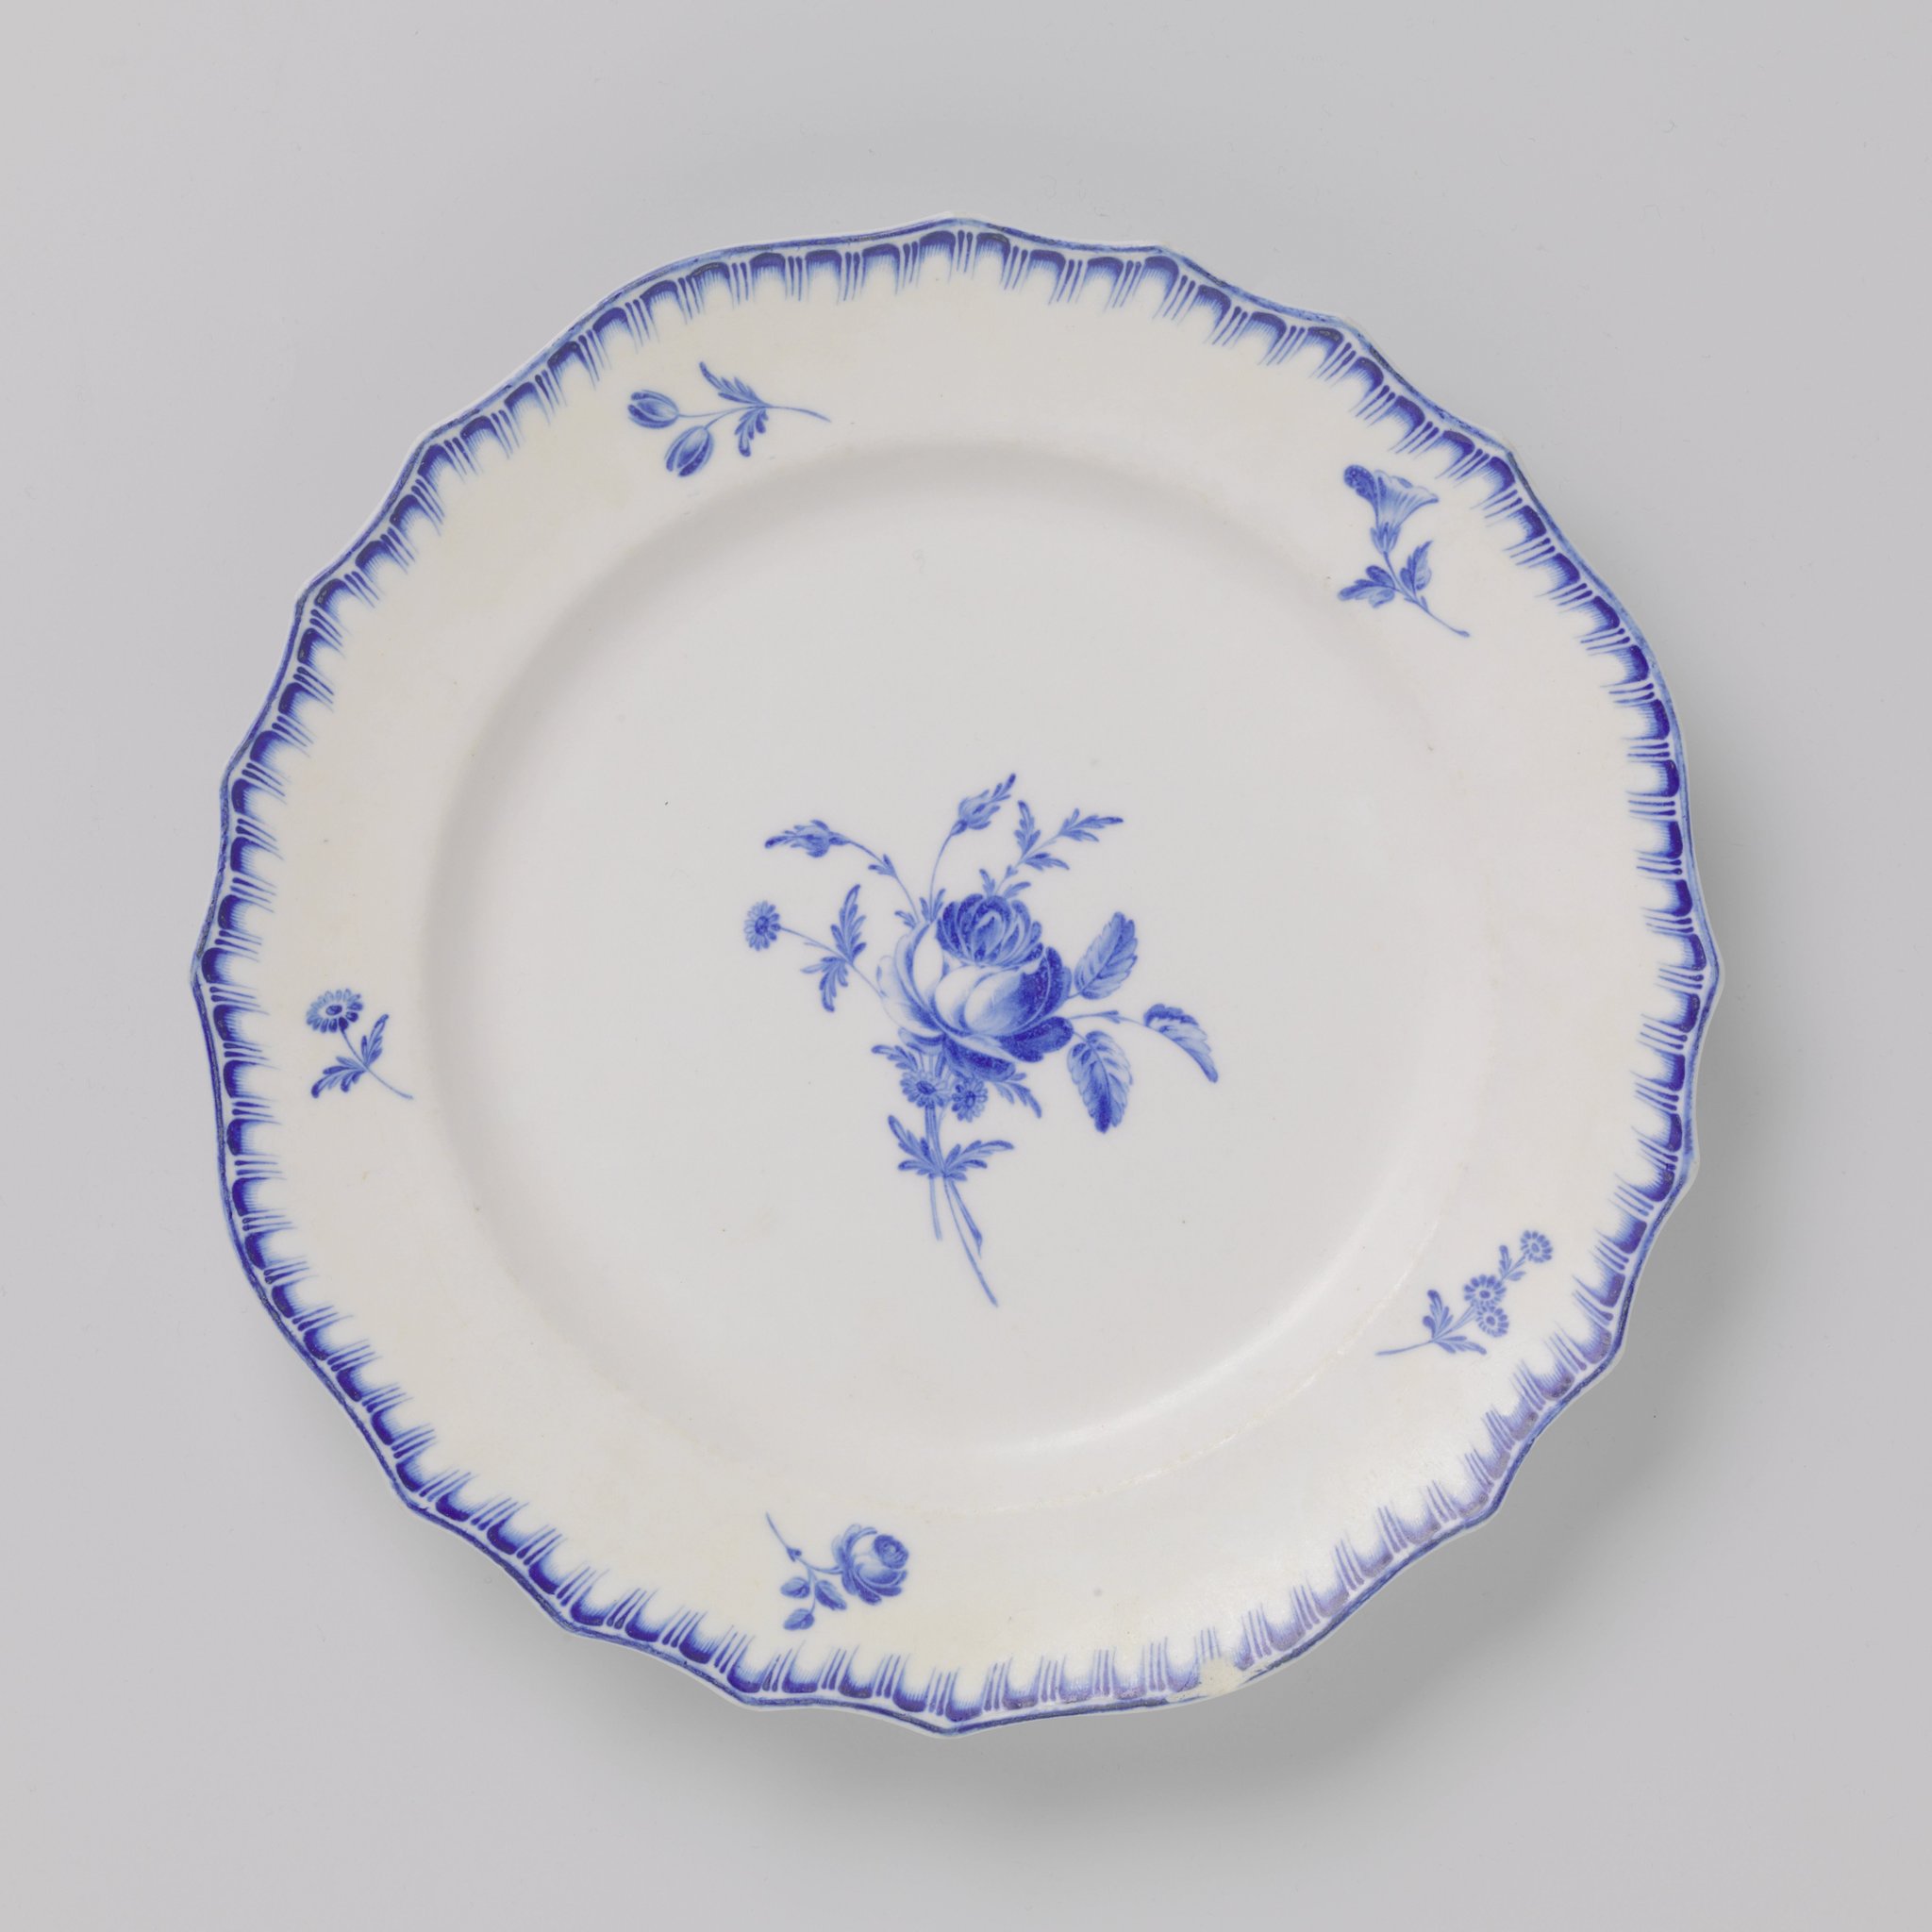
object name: plate dish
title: Plate with a bouquets and flowers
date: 1795-1805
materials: cobalt, glaze, paint, porcelain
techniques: firing, turning, vitrification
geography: doornik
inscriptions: mark: ‘gekruiste zwaarden met vier kruizen/ E?’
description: Bord van soft-paste porselein (pâte tendre) met een geschulpte rand, beschilderd in onderglazuur blauw. Op het plat een boeket van verschillende bloemen en op de rand vijf strooibloemen. Daarbuiten een decoratieve band (godronfries). Gemerkt op de onderzijde met de gekruiste zwaarden met vier kruizen en een E[?].